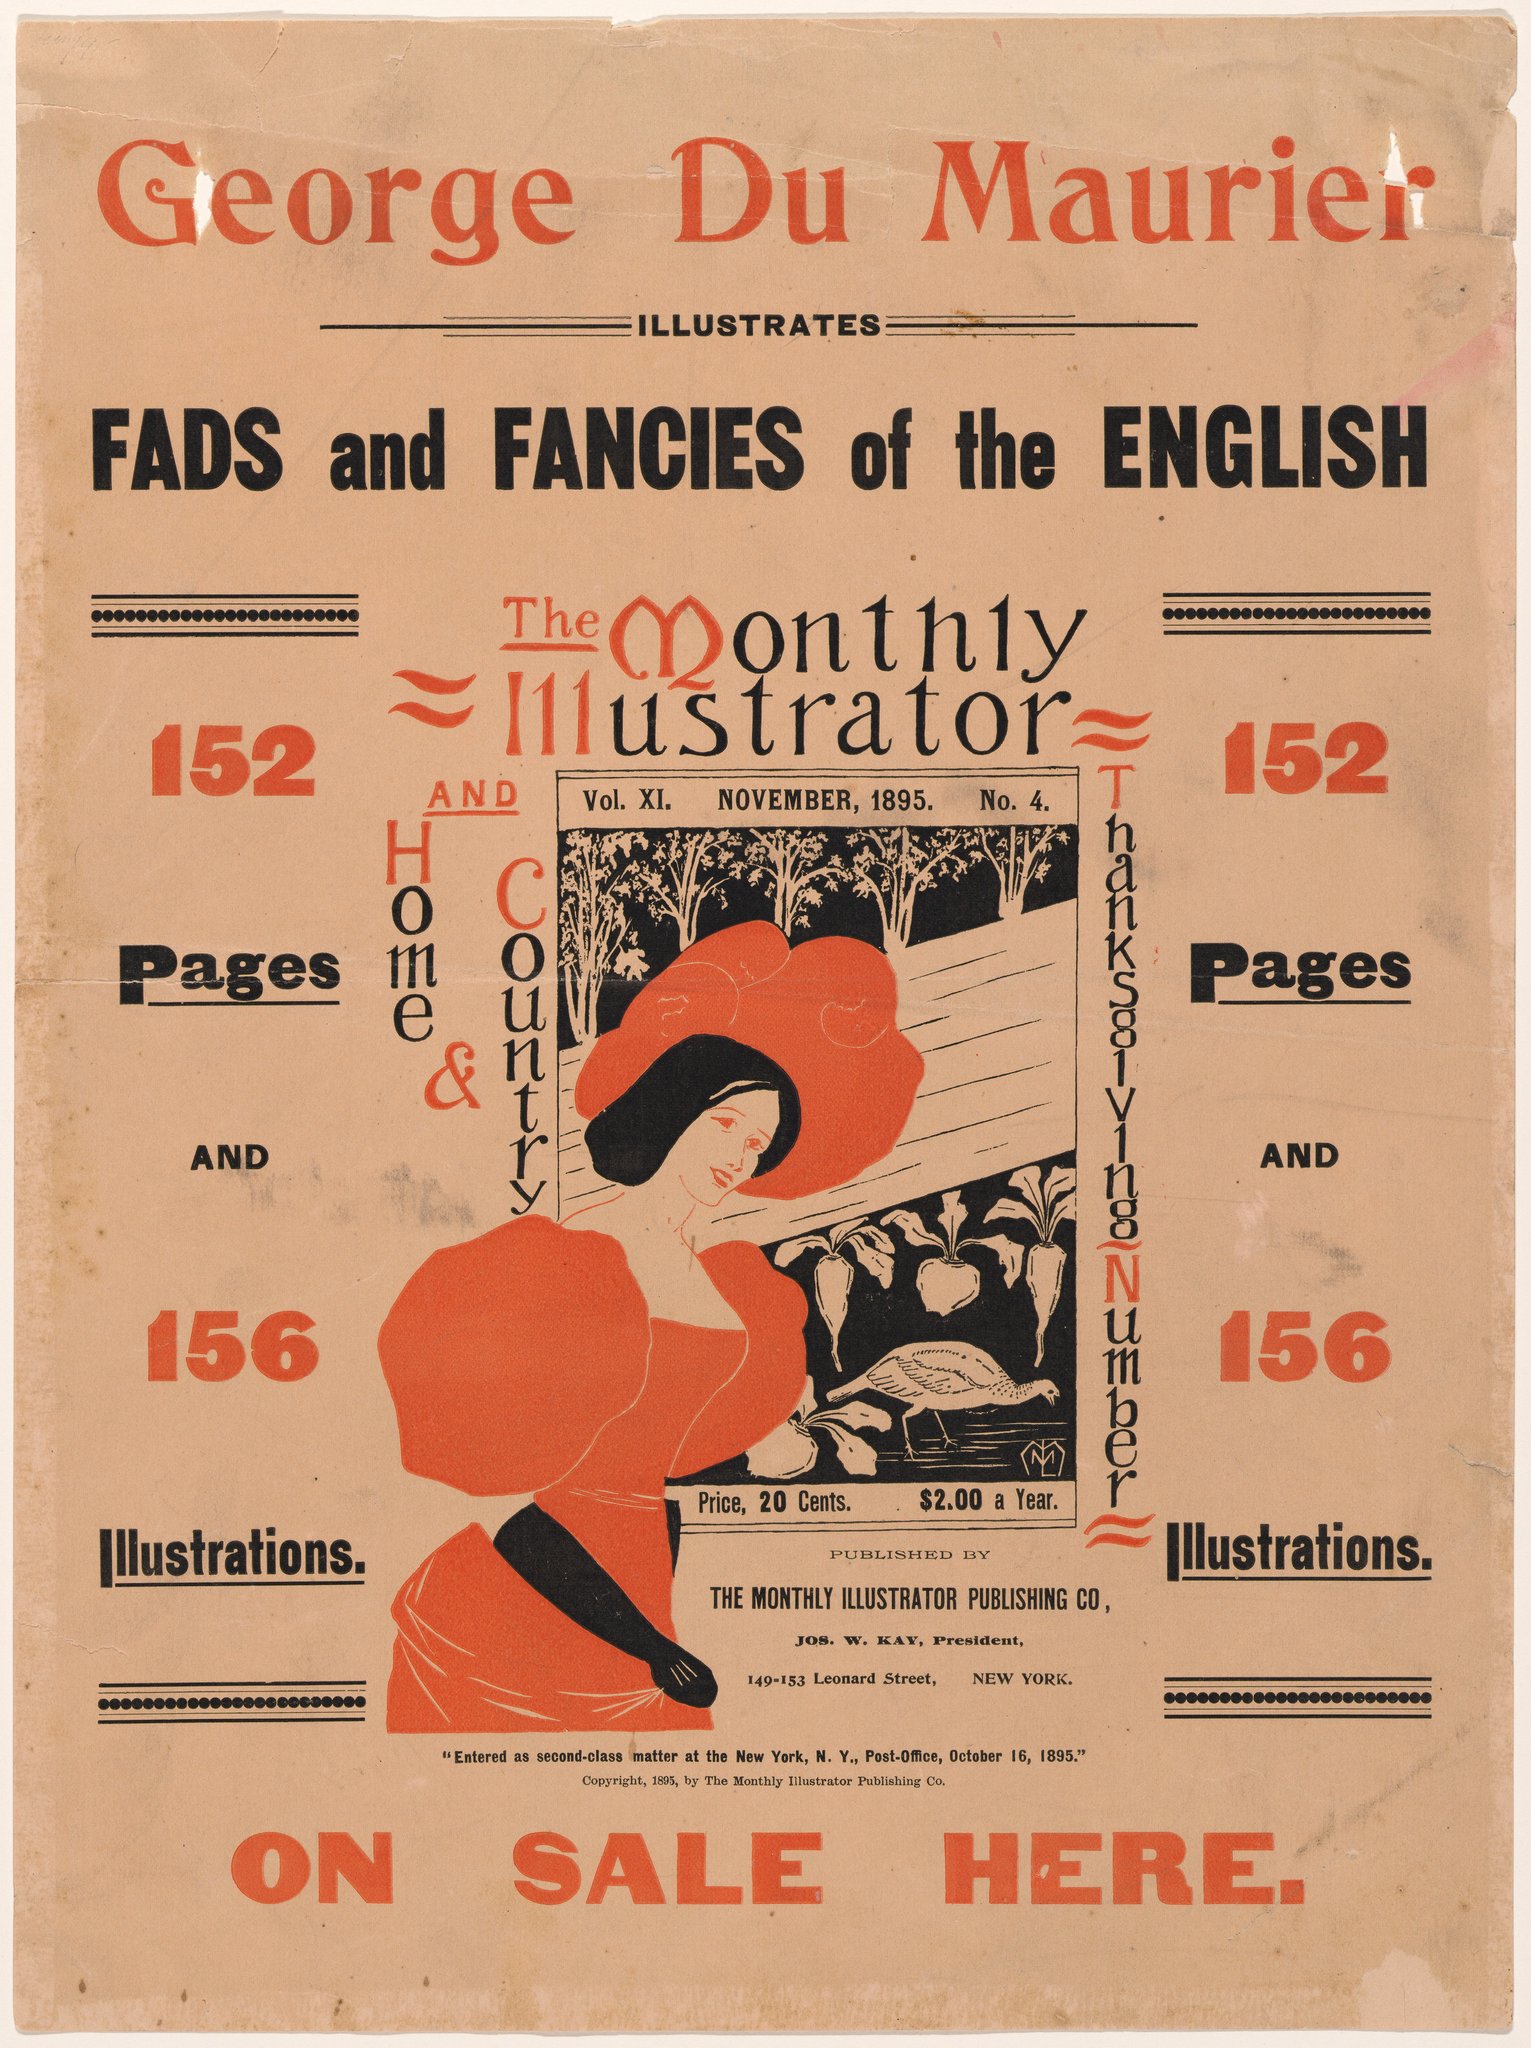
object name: print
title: The Monthly Illustrator, November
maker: anonymous, american, 19th century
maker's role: artist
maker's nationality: american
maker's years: 1800-1900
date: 1895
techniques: lithograph